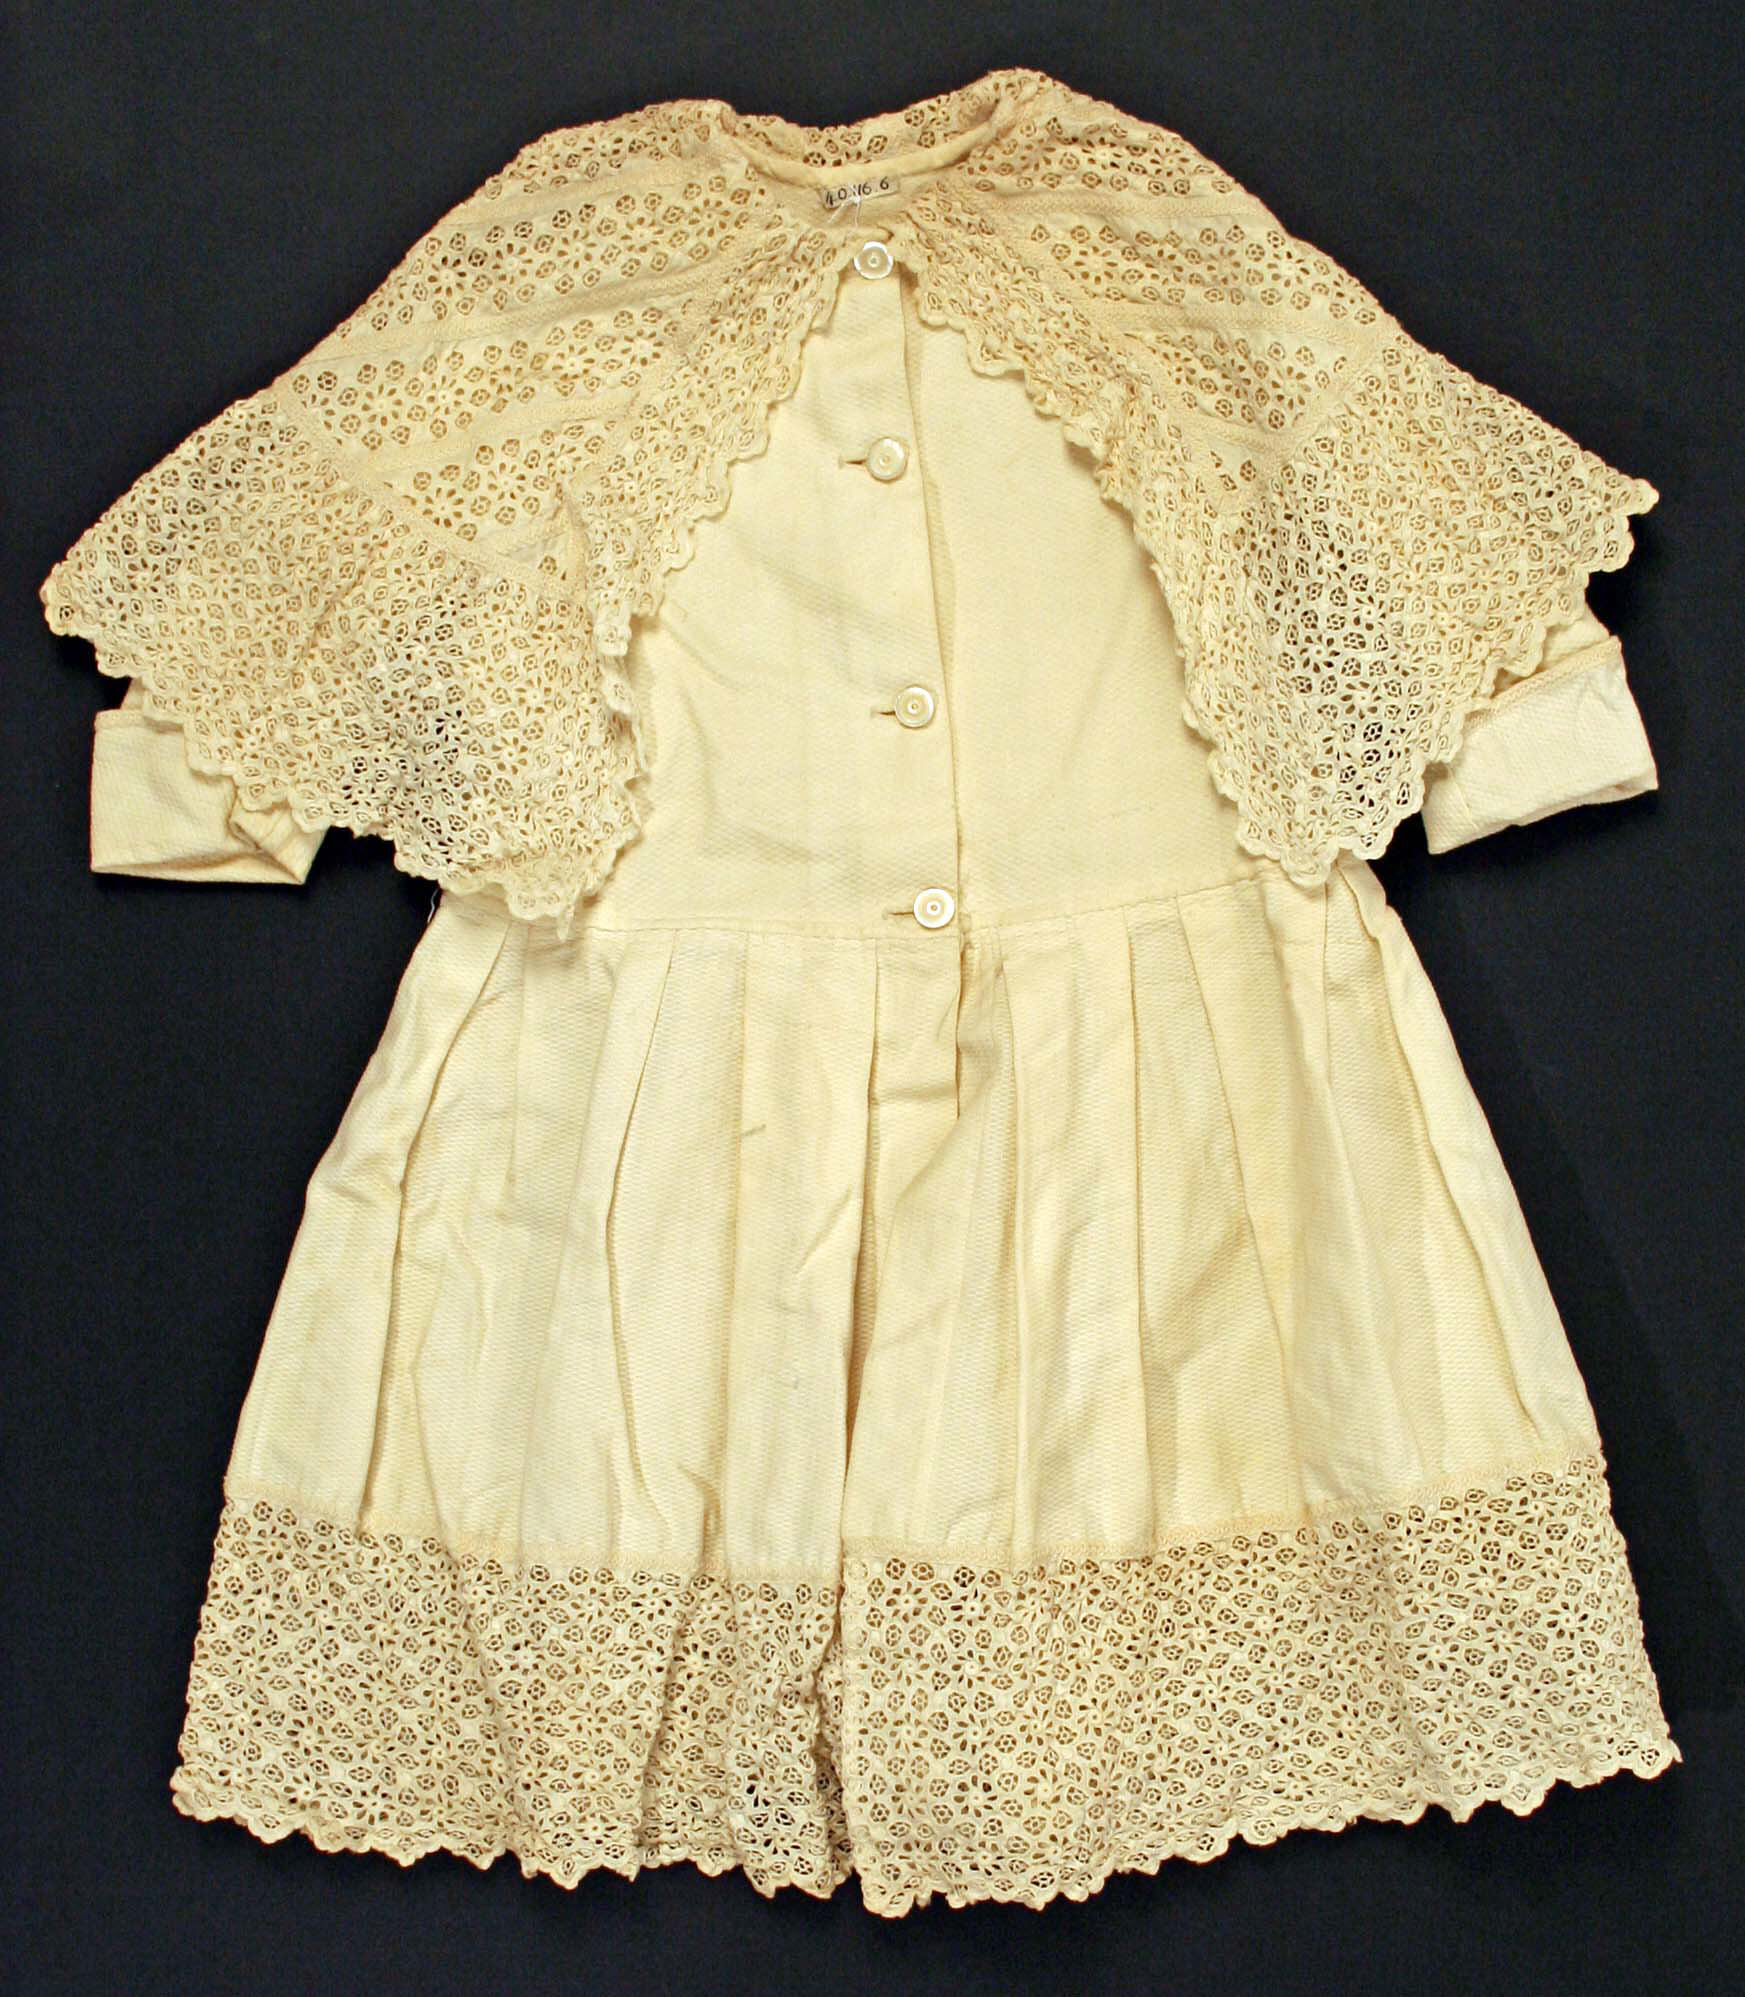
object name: coat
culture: american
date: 1886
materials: cotton